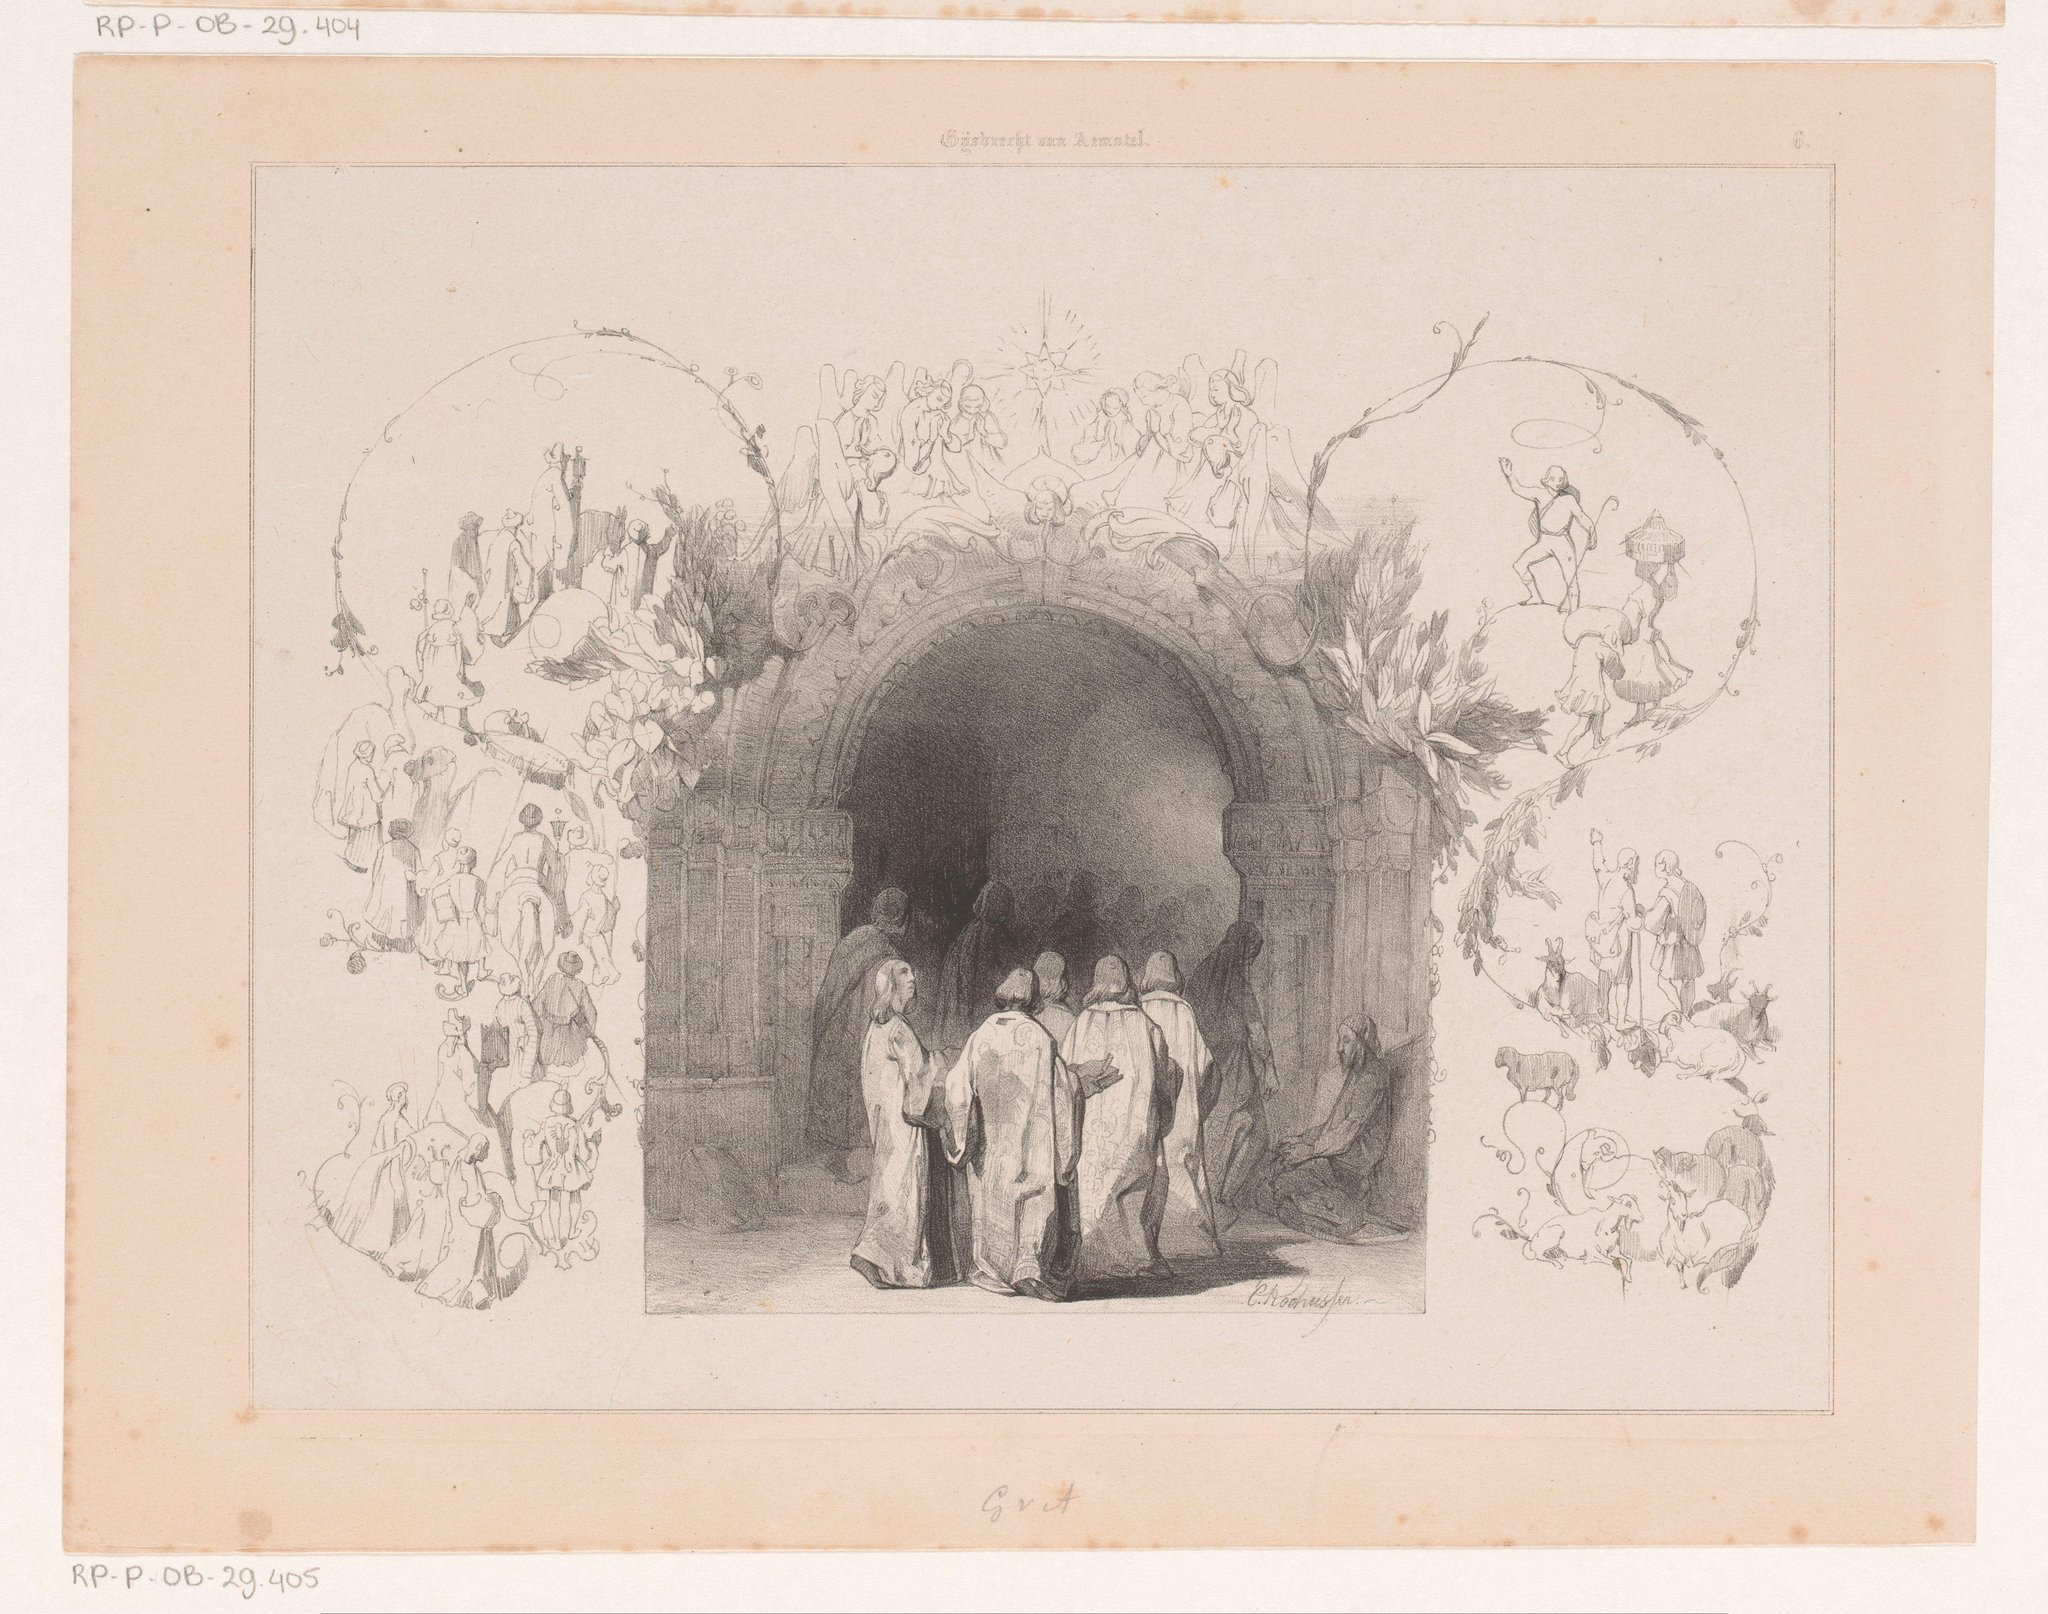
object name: book illustration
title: Religieuzen voor kerkportaal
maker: charles rochussen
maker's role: draughtsman, painter, print maker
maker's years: 1814-1894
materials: paper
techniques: lithograph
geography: the hague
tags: parts of church exterior and annexes: portal, organization, functionaries and dignitaries in roman catholic church; clergy in general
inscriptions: collector's mark: Lugt 2228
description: Prent uit: Vondel, Joost van den. Gysbrecht van Aemstel, treurspel. Den Haag: Nederlandsche Maatschappij van Schoone Kunsten, 1841.